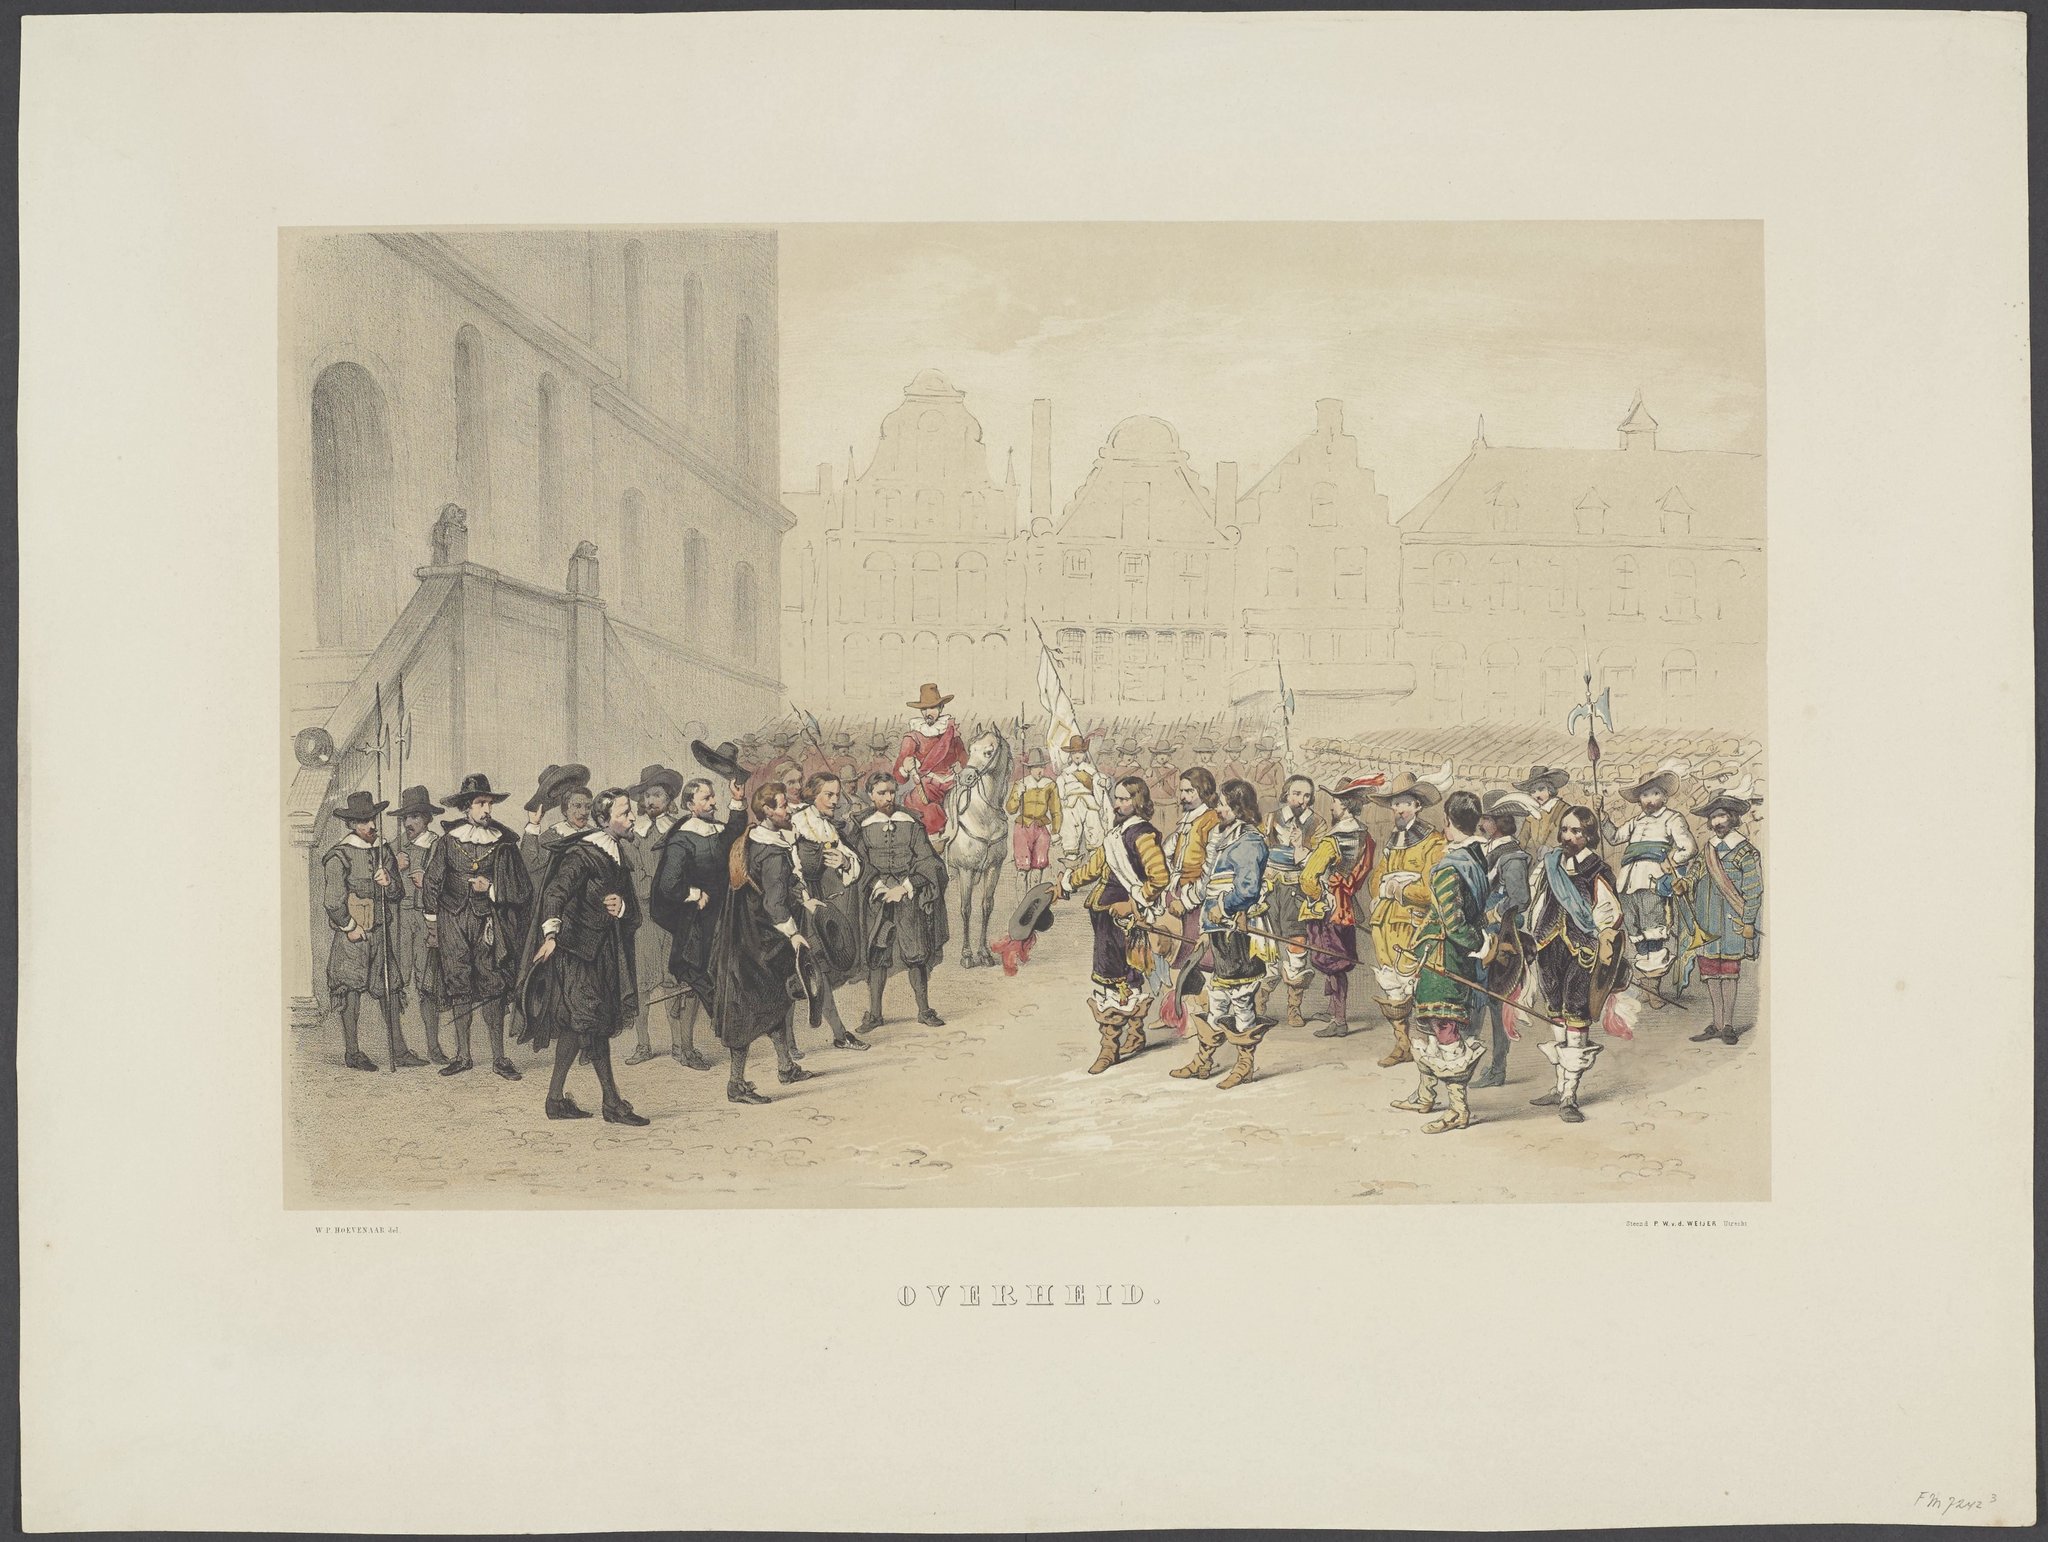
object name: print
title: Ons vaderland omstreeks het midden der 17e eeuw, voorgesteld door H.H. studenten, leden van Mutua Fides, ter viering van het 220jarig bestaan der Utrechtsche Hoogeschool, den 25. Junij 1856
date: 1856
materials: paper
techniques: hand coloring, lithograph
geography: netherlands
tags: students' pageant, costumes used in pageants, utrecht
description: Op een plein voor een stadhuis begroeten officieren van de schutterij (rechts) de burgemeesters, baljuw en vroedschappen (links). In de achtergrond vullen de leden van de schutterij het plein. Onderdeel van de groep van zeven platen met verklaring van de historische optocht in maskerade opgevoerd door de studenten van de vereniging Mutua Fides van de Utrechtse Hogeschool op 25 juni 1856 ter gelegenheid van de viering van haar 220-jarige bestaan.